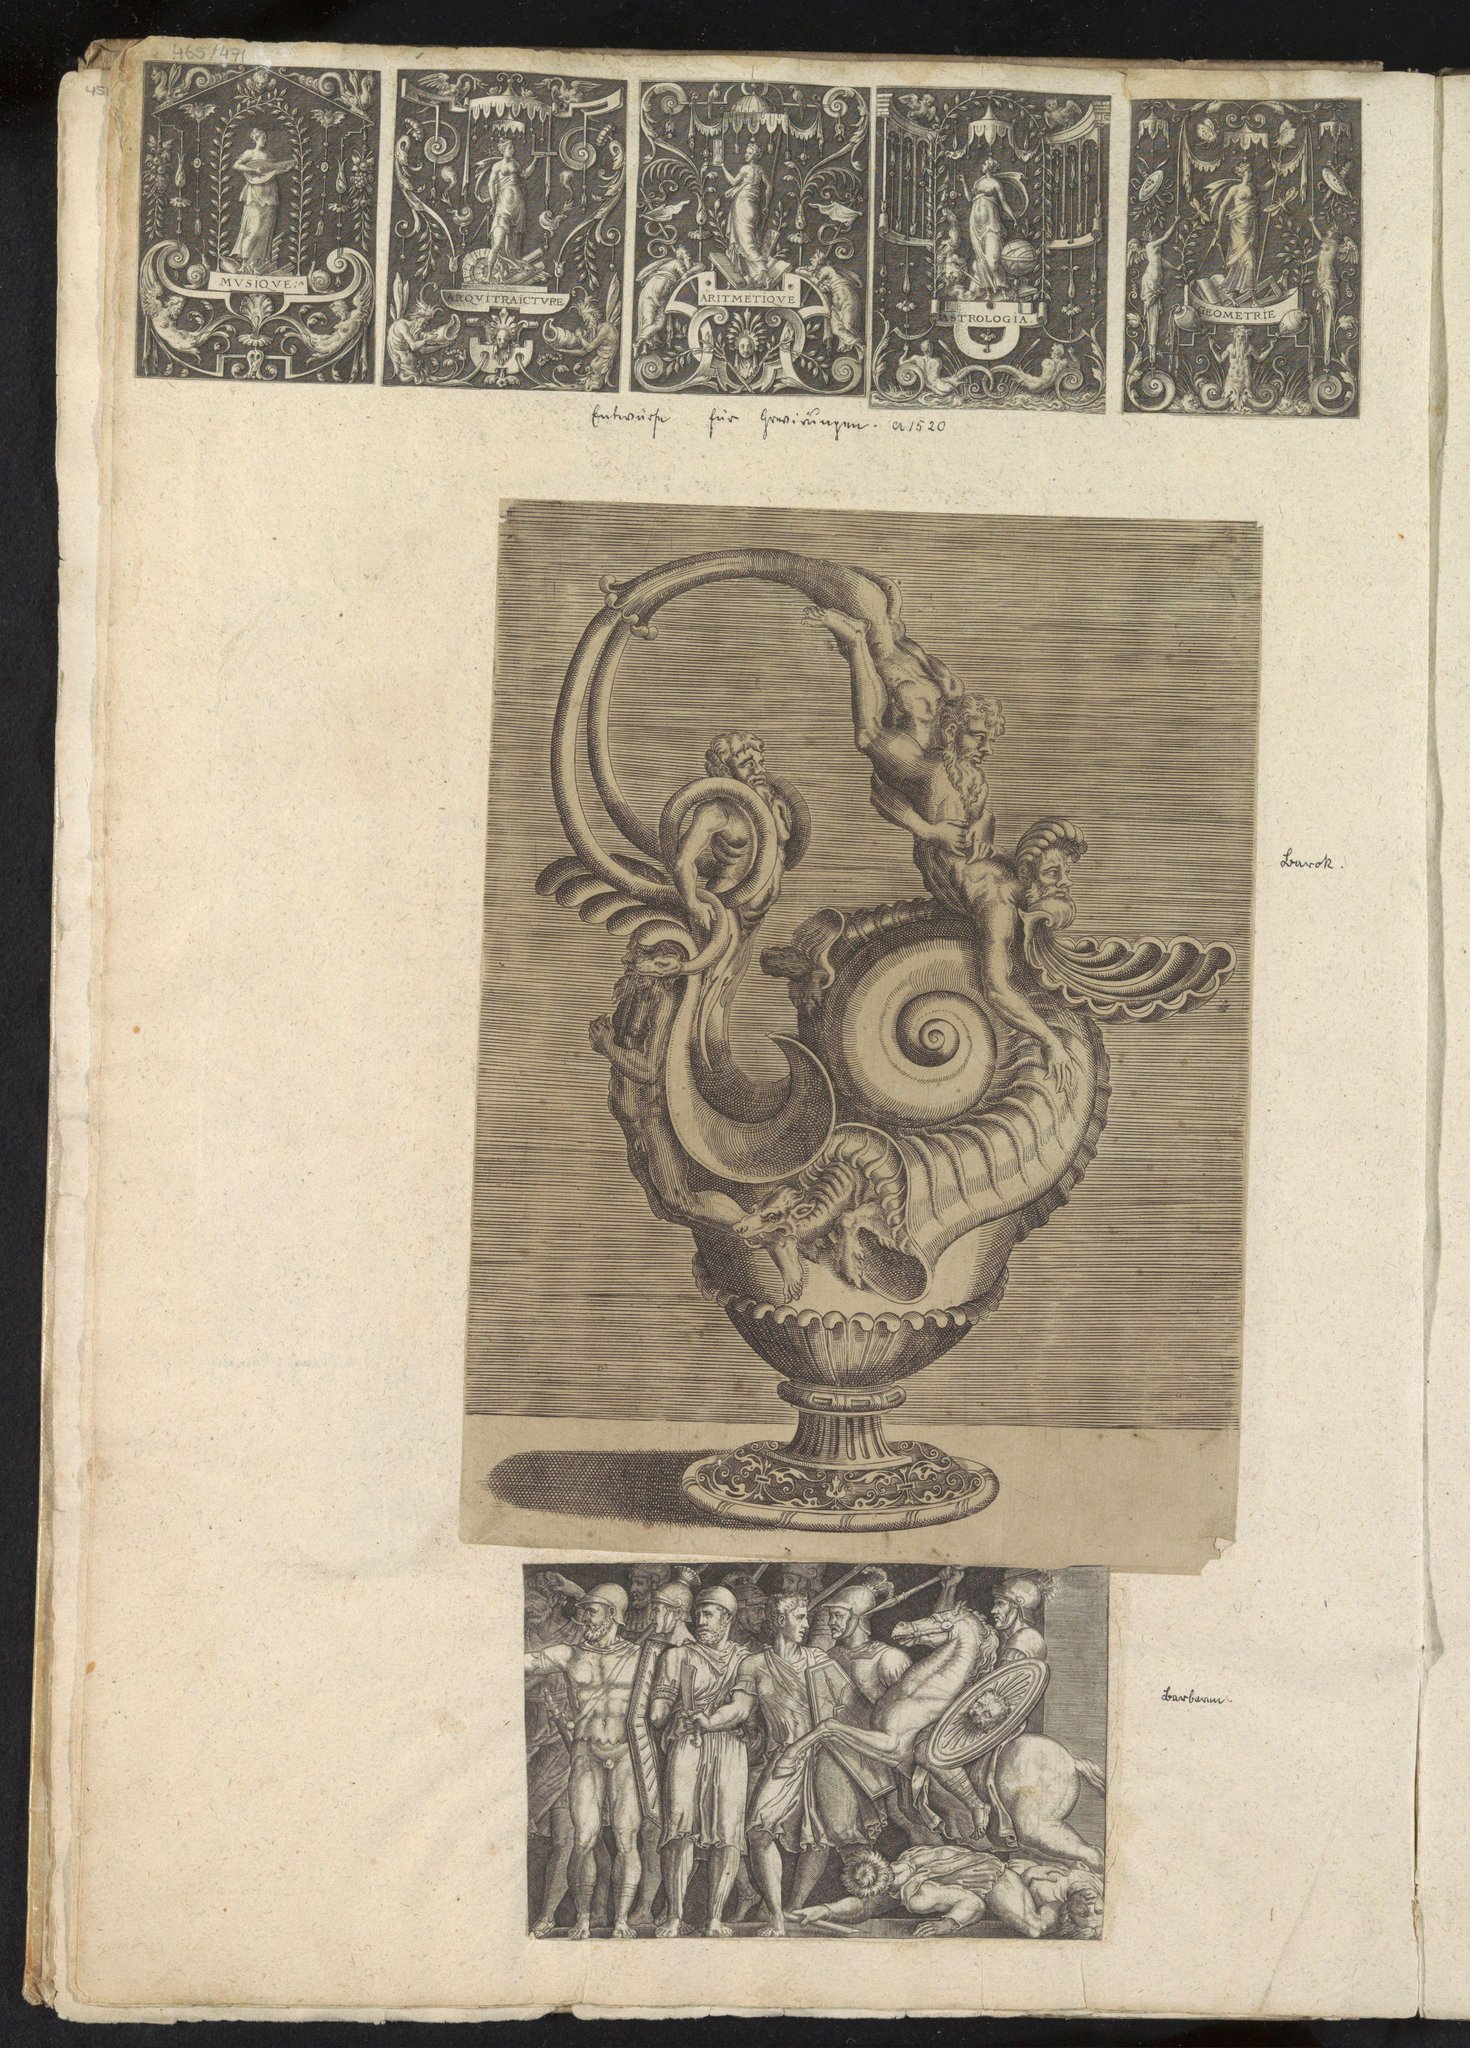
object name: print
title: Albumblad met zeven prenten met personificaties van de Vrije Kunsten, een kan en Romeinse soldaten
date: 1500-1599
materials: paper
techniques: engraving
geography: antwerp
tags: kitchen-utensils: cauldron, quadrivium (personification of arithmetica, geometria, astronomia, and musica), 'musica', symbolic representations, allegories and emblems ~ music; 'musica'(ripa), 'arithmetica' (~ quadrivium); 'aritmetica' (ripa), 'geometria' (~ quadrivium); 'geometria' (ripa), 'astrologia' (ripa), the soldier; the soldier's life, 'architectura', symbolic representations, allegories and emblems ~ architecture; 'architettura' (ripa)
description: Albumblad met zeven uitgeknipte prenten: vijf voorstellingen van personificaties van de Vrije Kunsten, een ornamentele kan en een groep Romeinse soldaten.